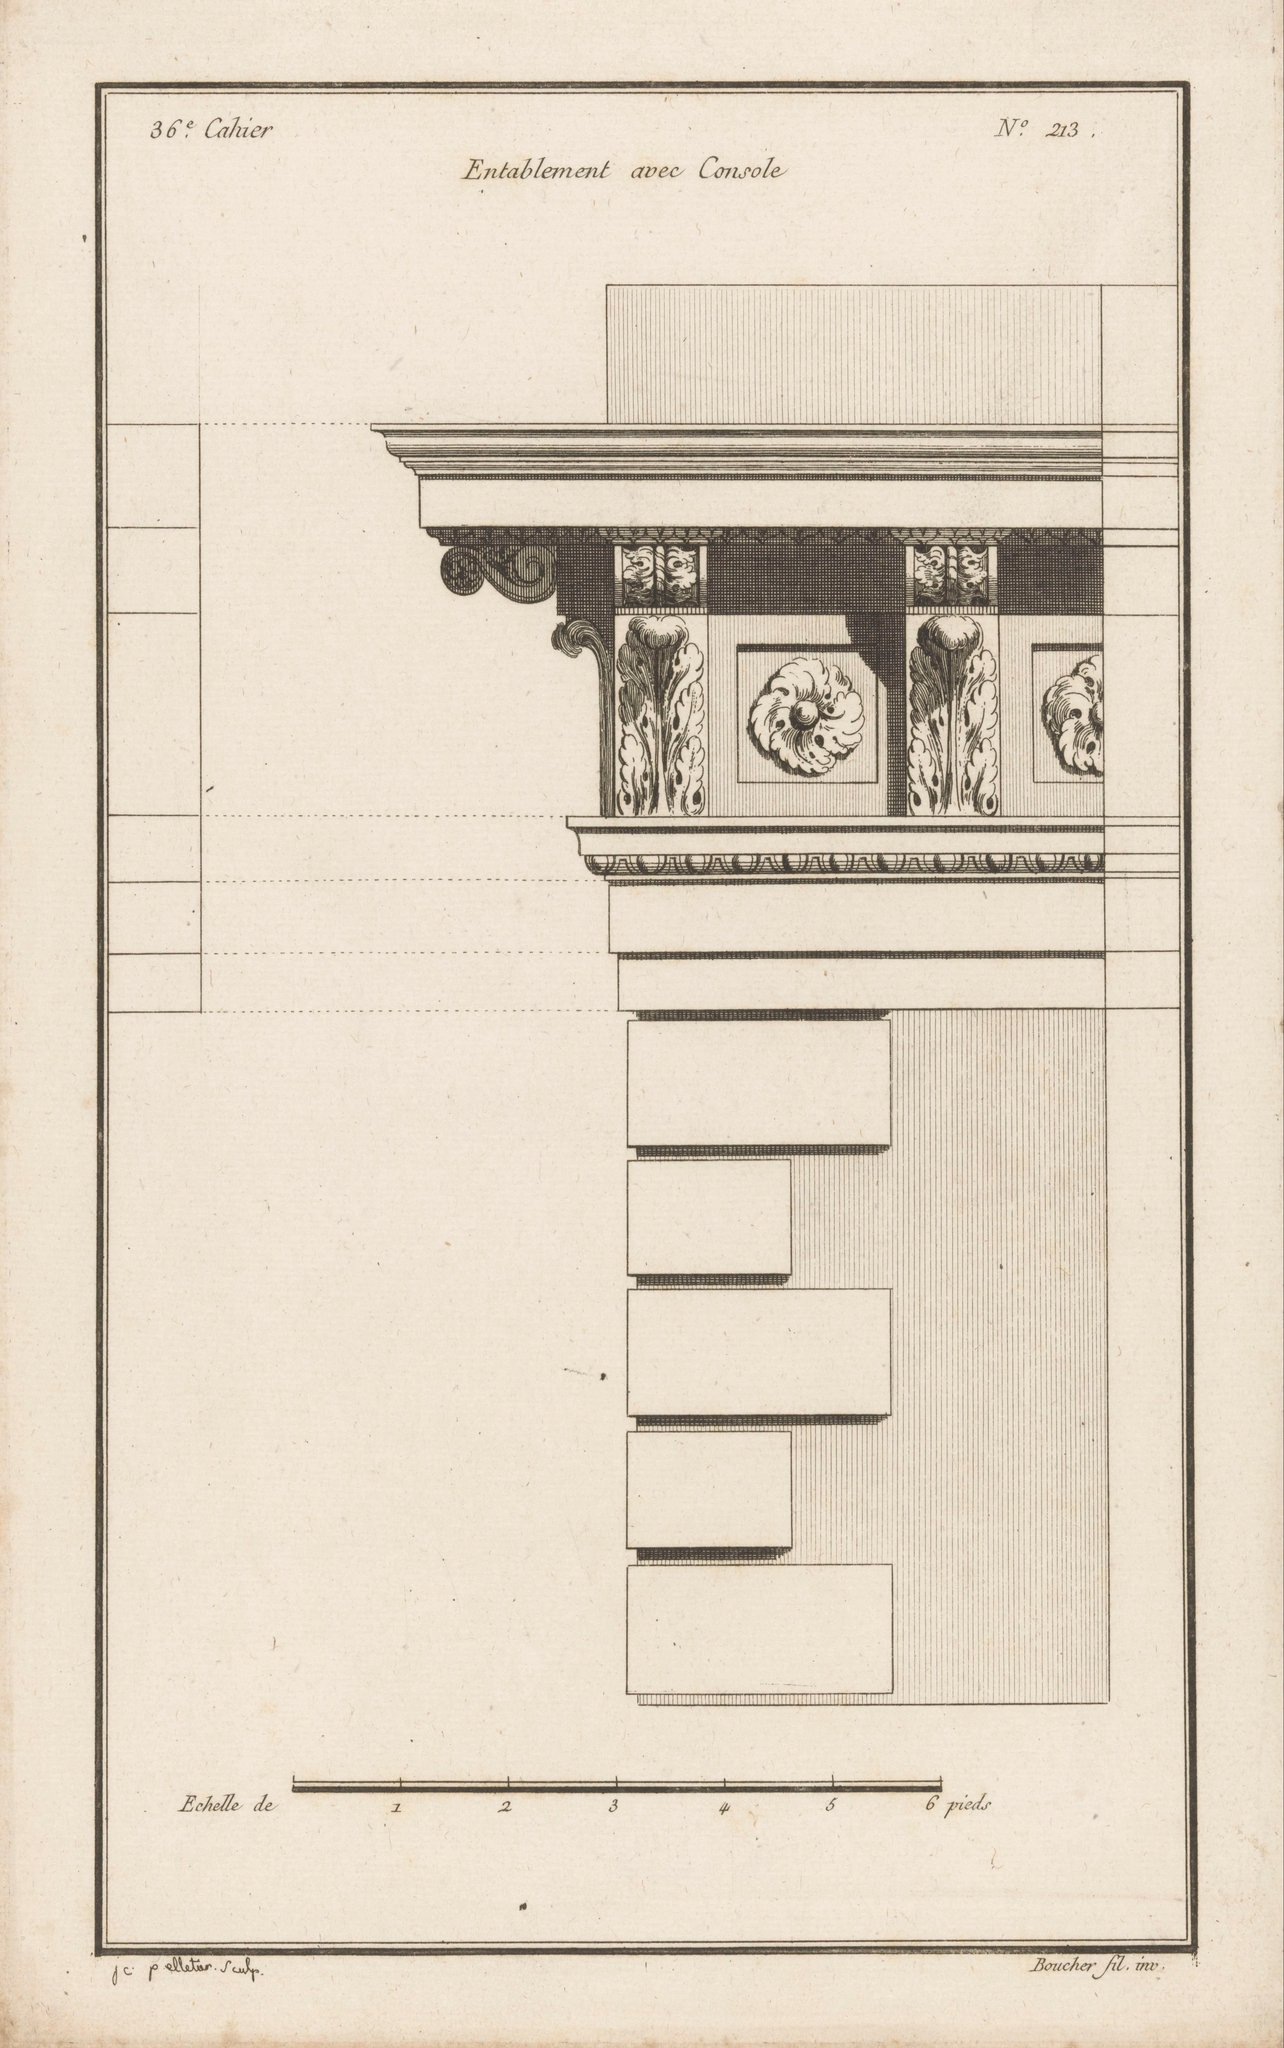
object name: ornament print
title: Hoofdgestel met console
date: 1772-1779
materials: paper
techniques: engraving, etching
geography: paris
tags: other architectural details (console), other architectural details (entablature)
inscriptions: collector's mark: Lugt 2228, collector's mark: Lugt 2760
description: Een hoofdgestel met geornamenteerde consoles, met bladmotieven. Prentnummer 213.